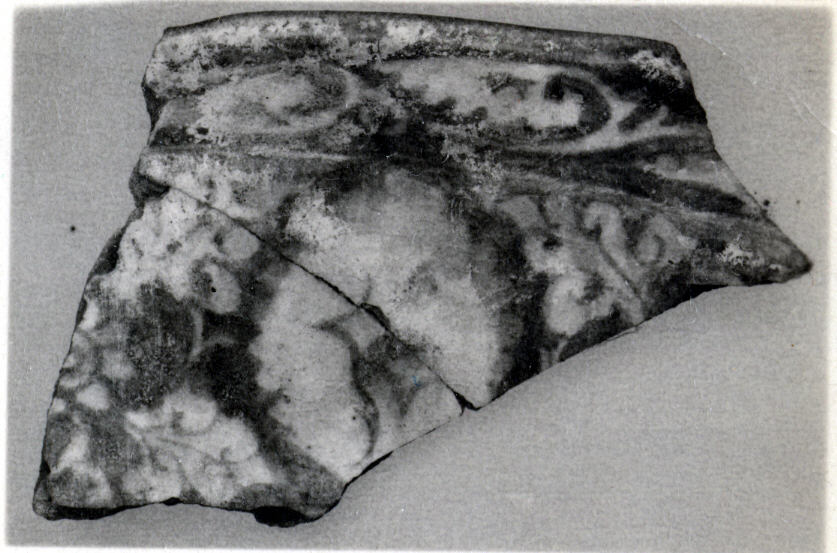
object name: fragment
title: Ceramic Fragment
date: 1501-1600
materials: earthenware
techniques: glazing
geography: iran